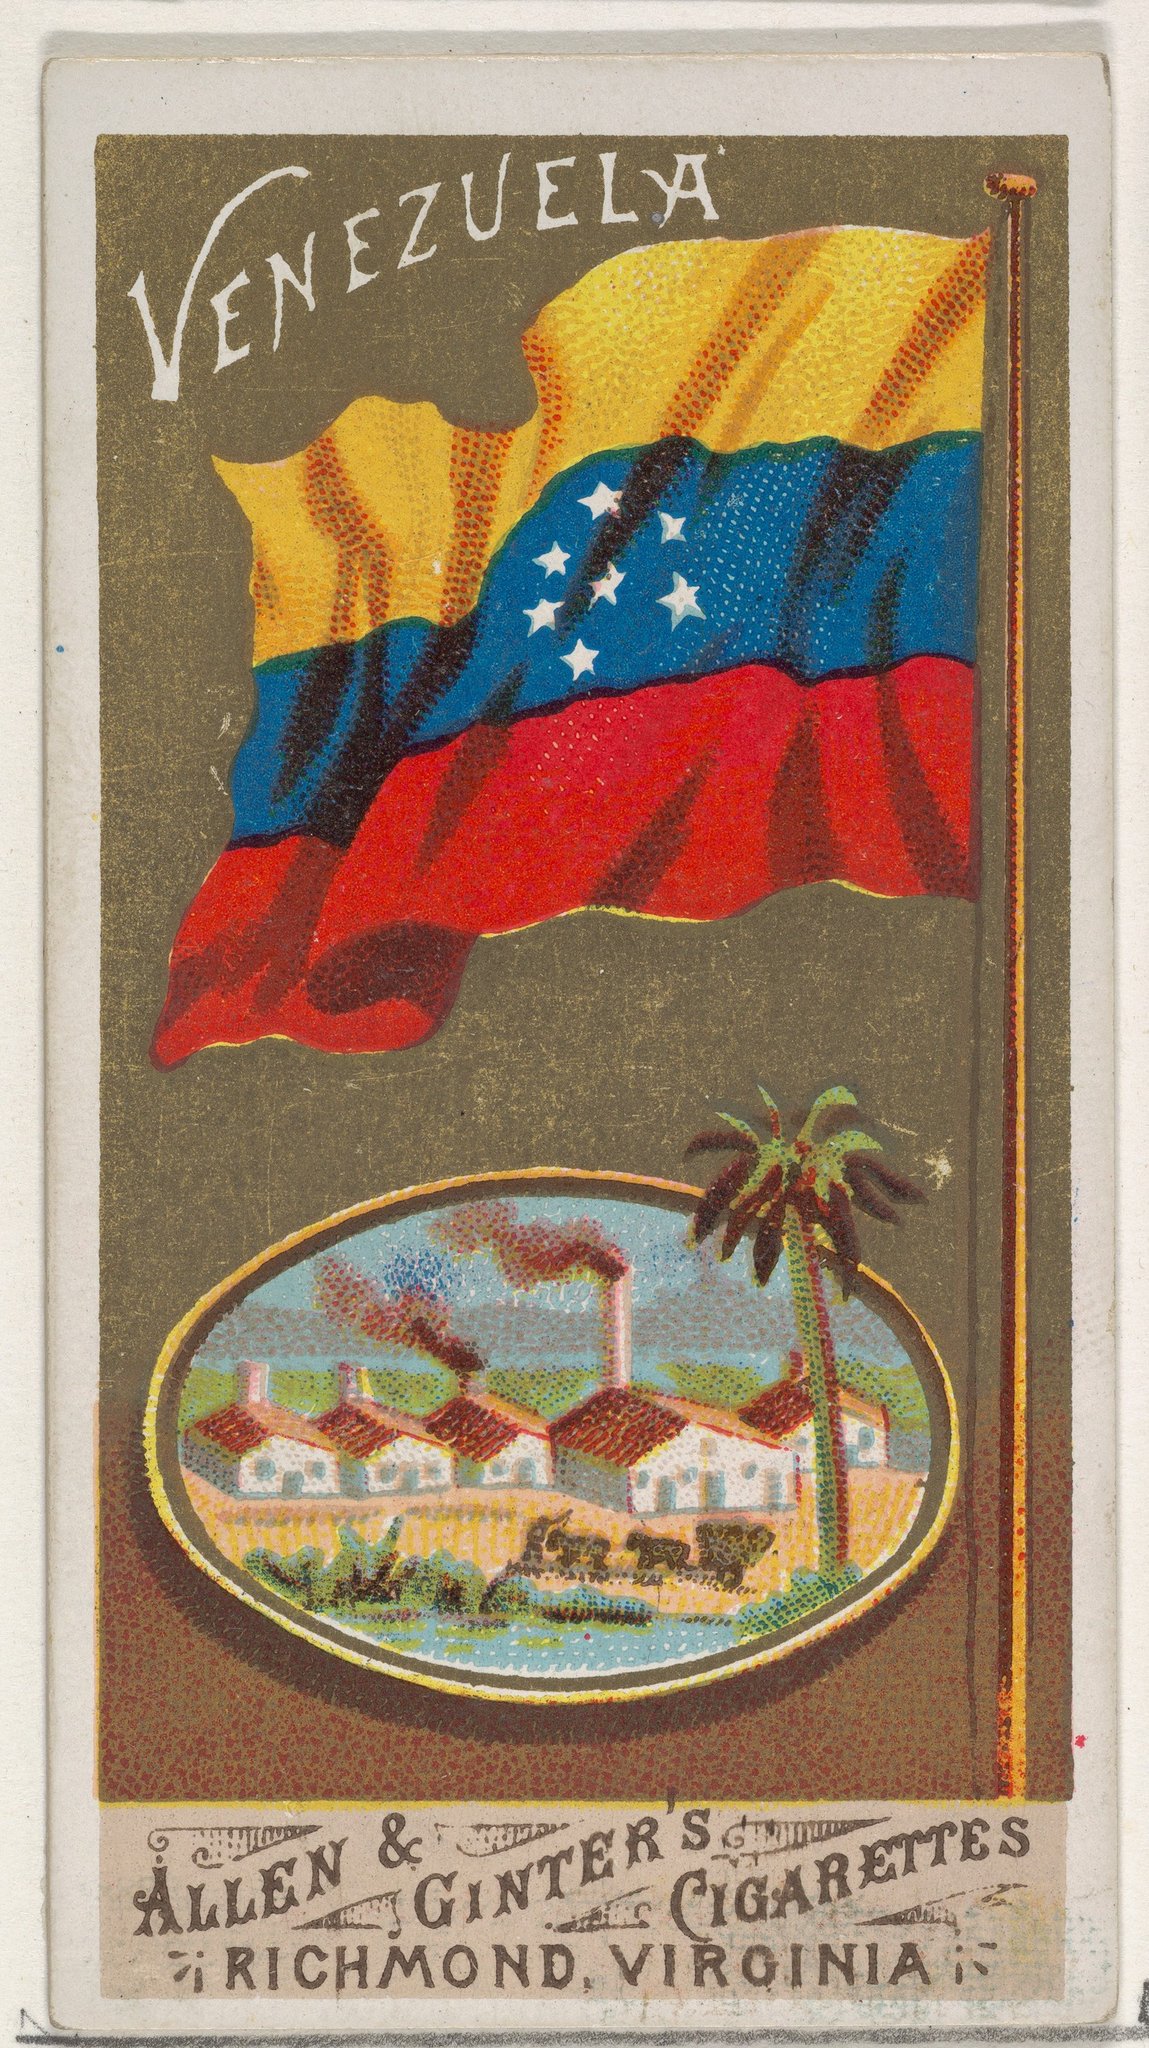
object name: print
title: Venezuela, from Flags of All Nations, Series 1 (N9) for Allen & Ginter Cigarettes Brands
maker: allen & ginter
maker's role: publisher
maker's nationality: american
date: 1887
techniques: color lithograph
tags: flags